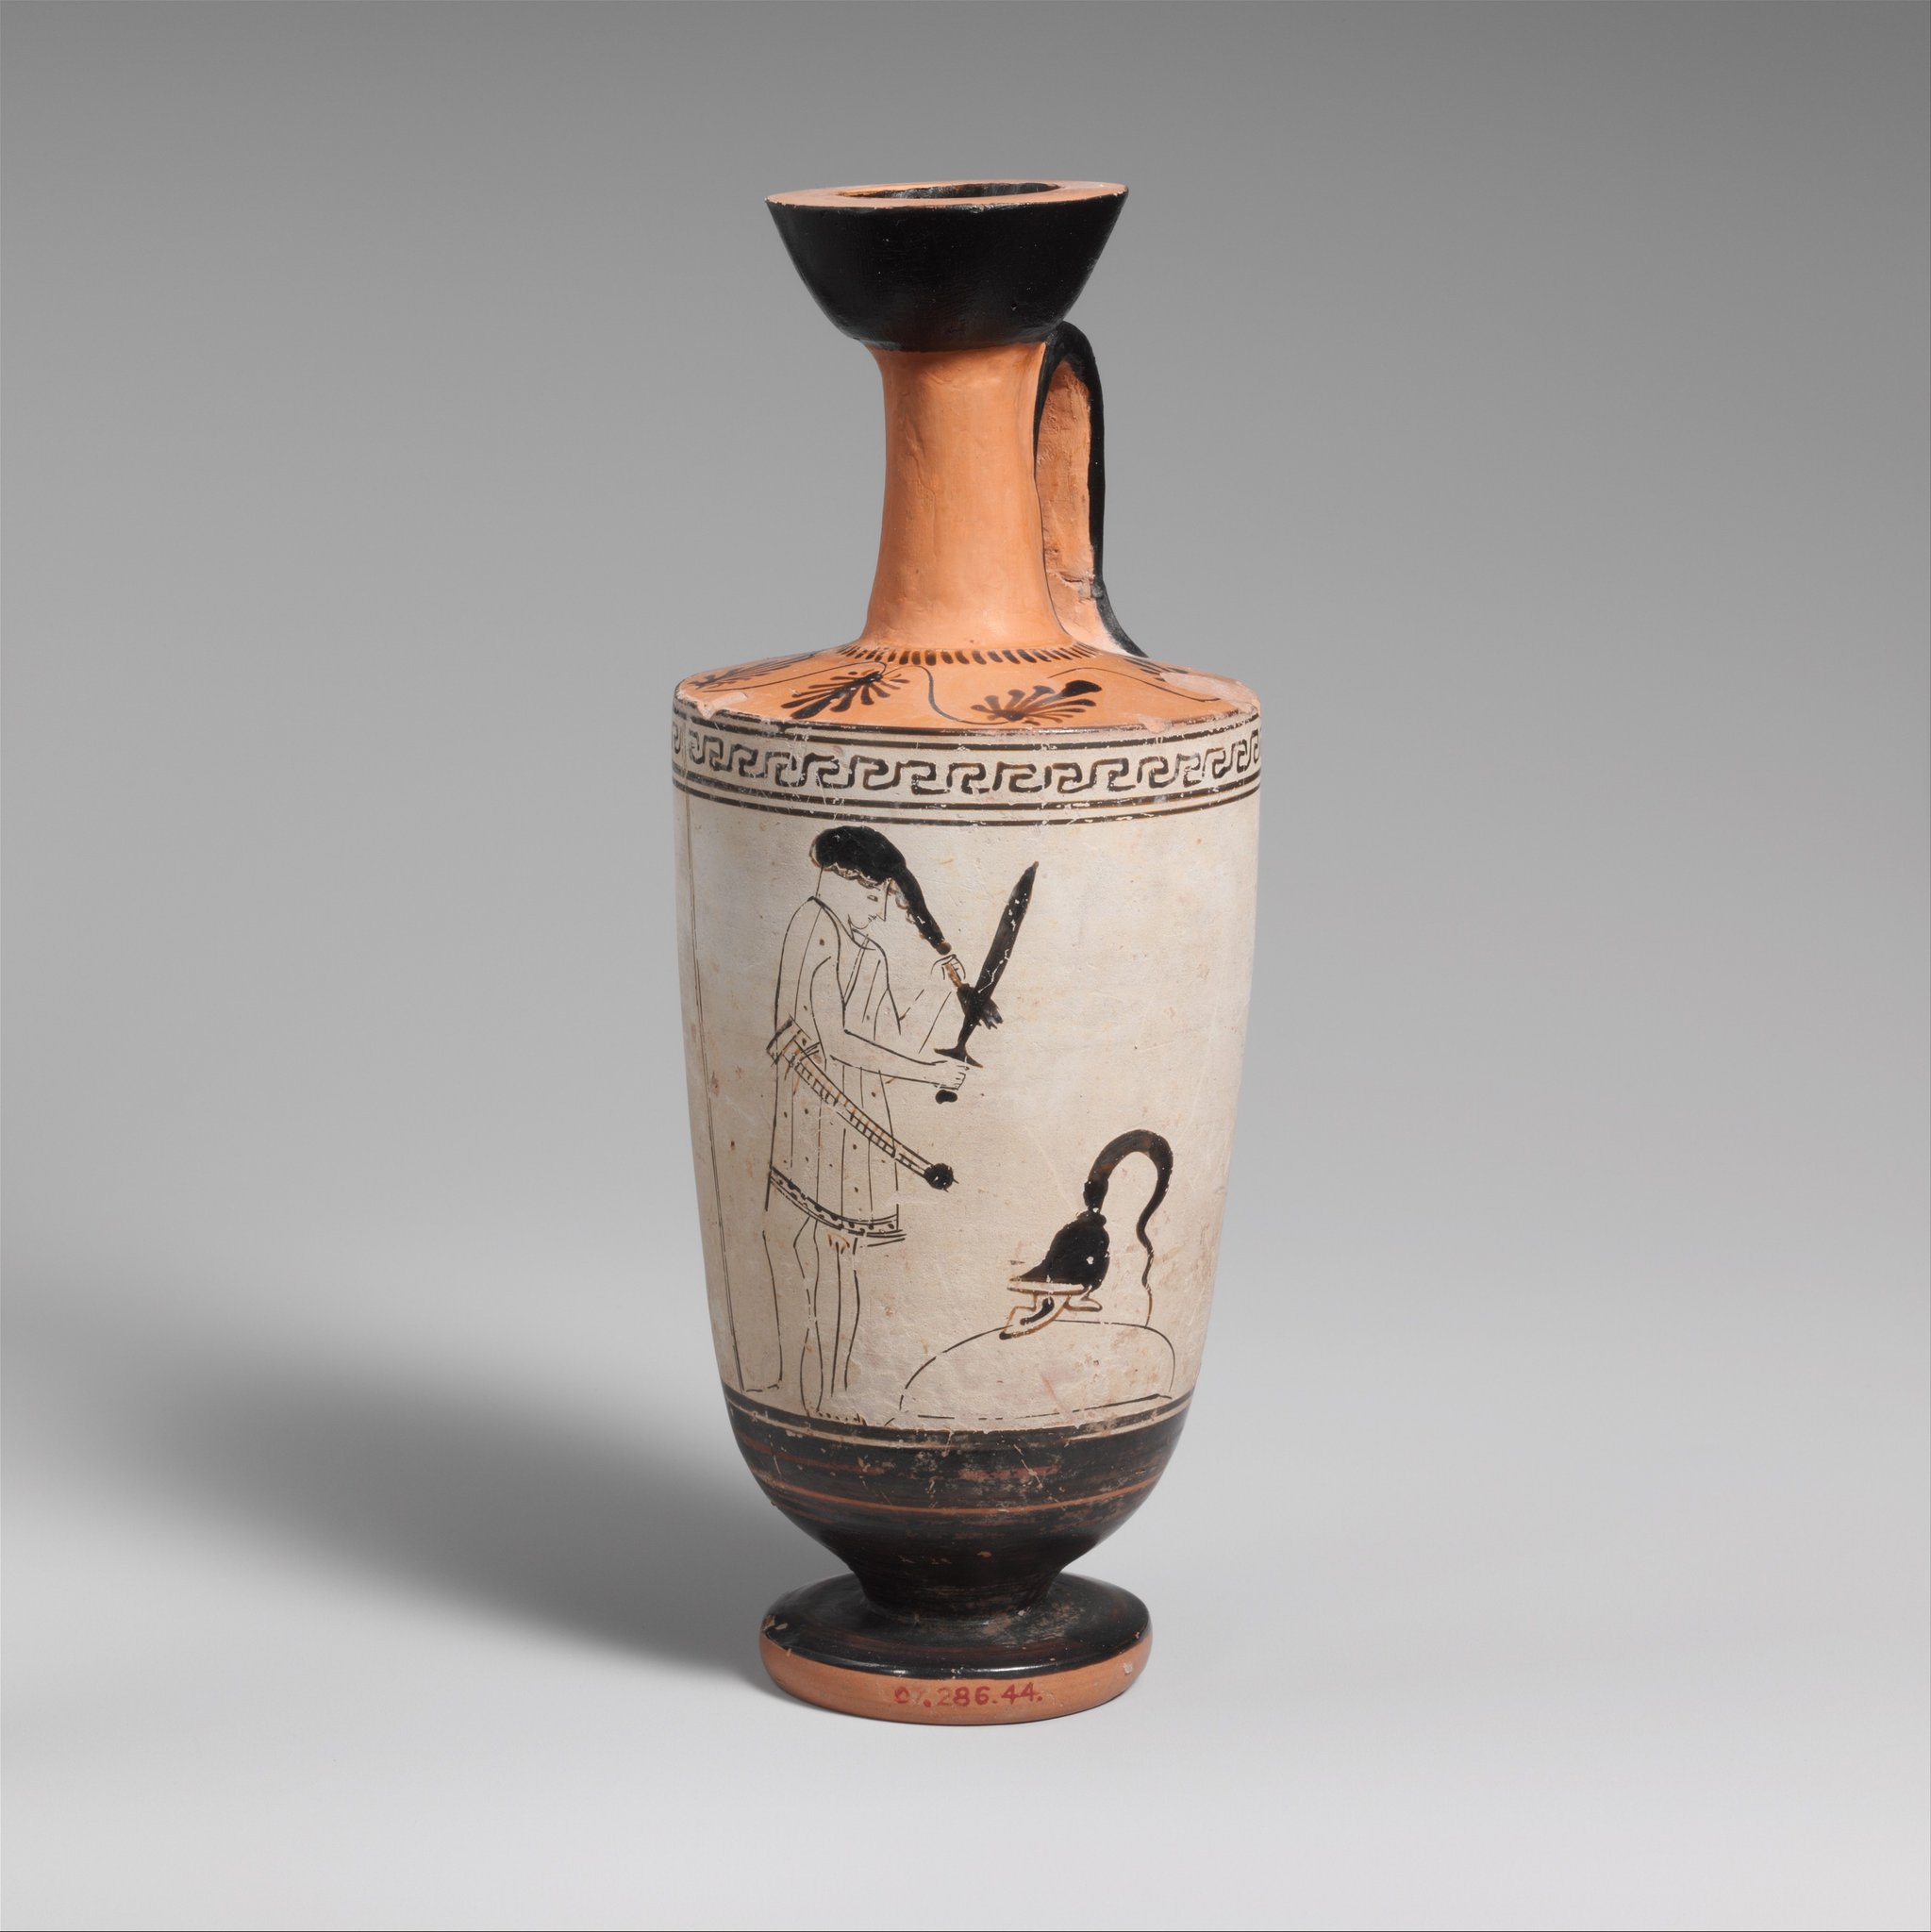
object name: lekythos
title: Terracotta lekythos (oil flask)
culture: greek, attic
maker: painter of the yale lekythos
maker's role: artist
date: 470-460 BCE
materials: terracotta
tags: helmets,swords,hair,men,warriors